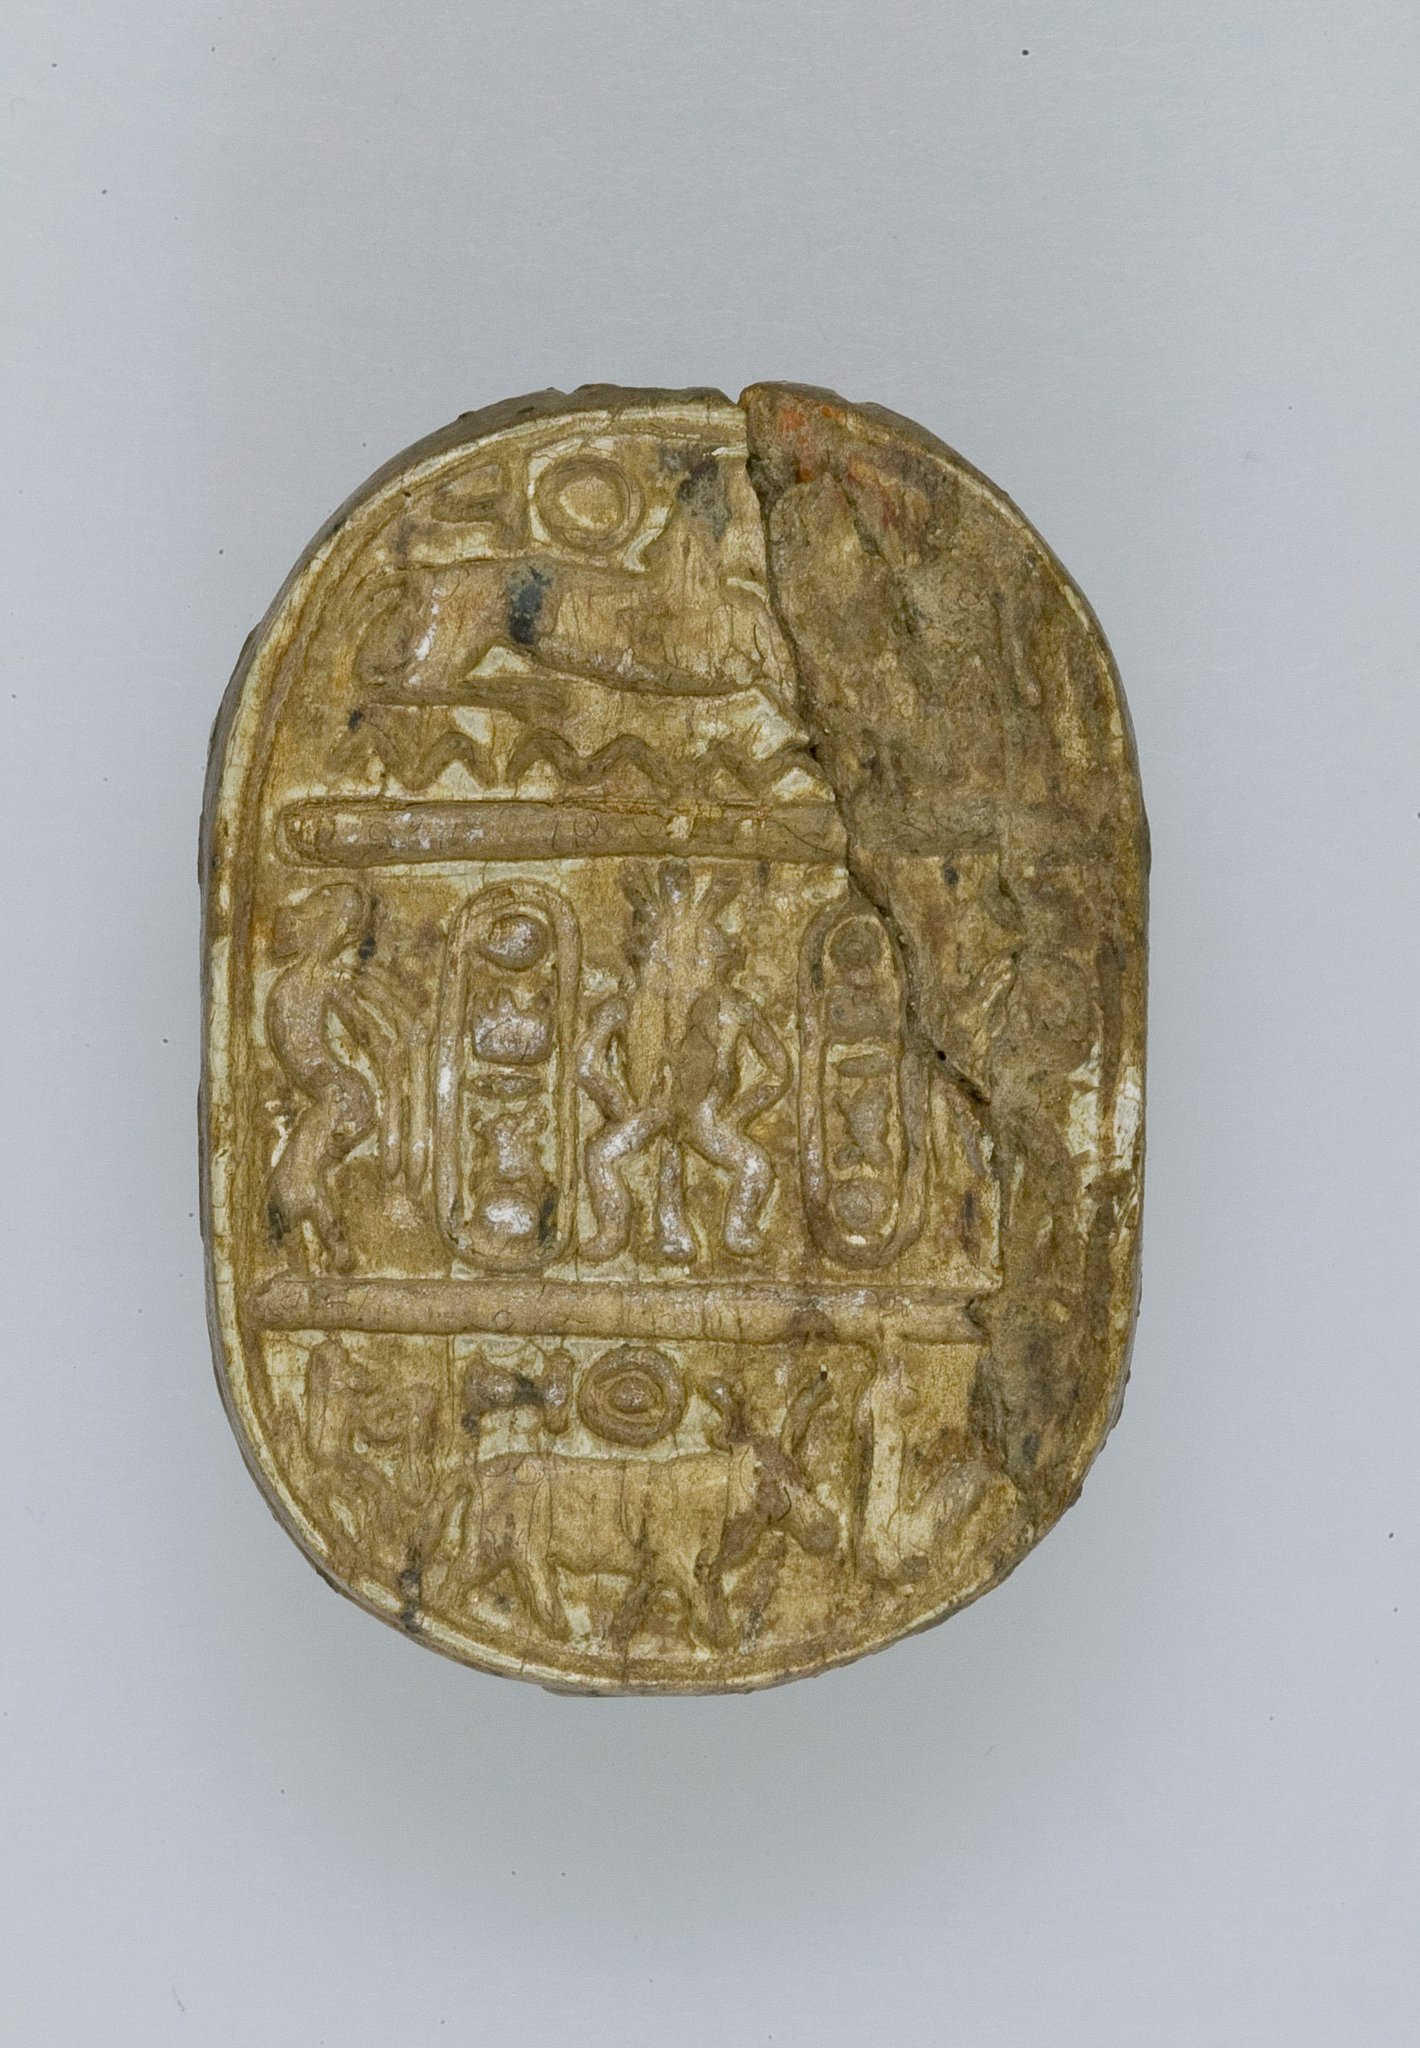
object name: scarab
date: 1295-1070 BCE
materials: stone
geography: egypt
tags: hieroglyphs,scarabs